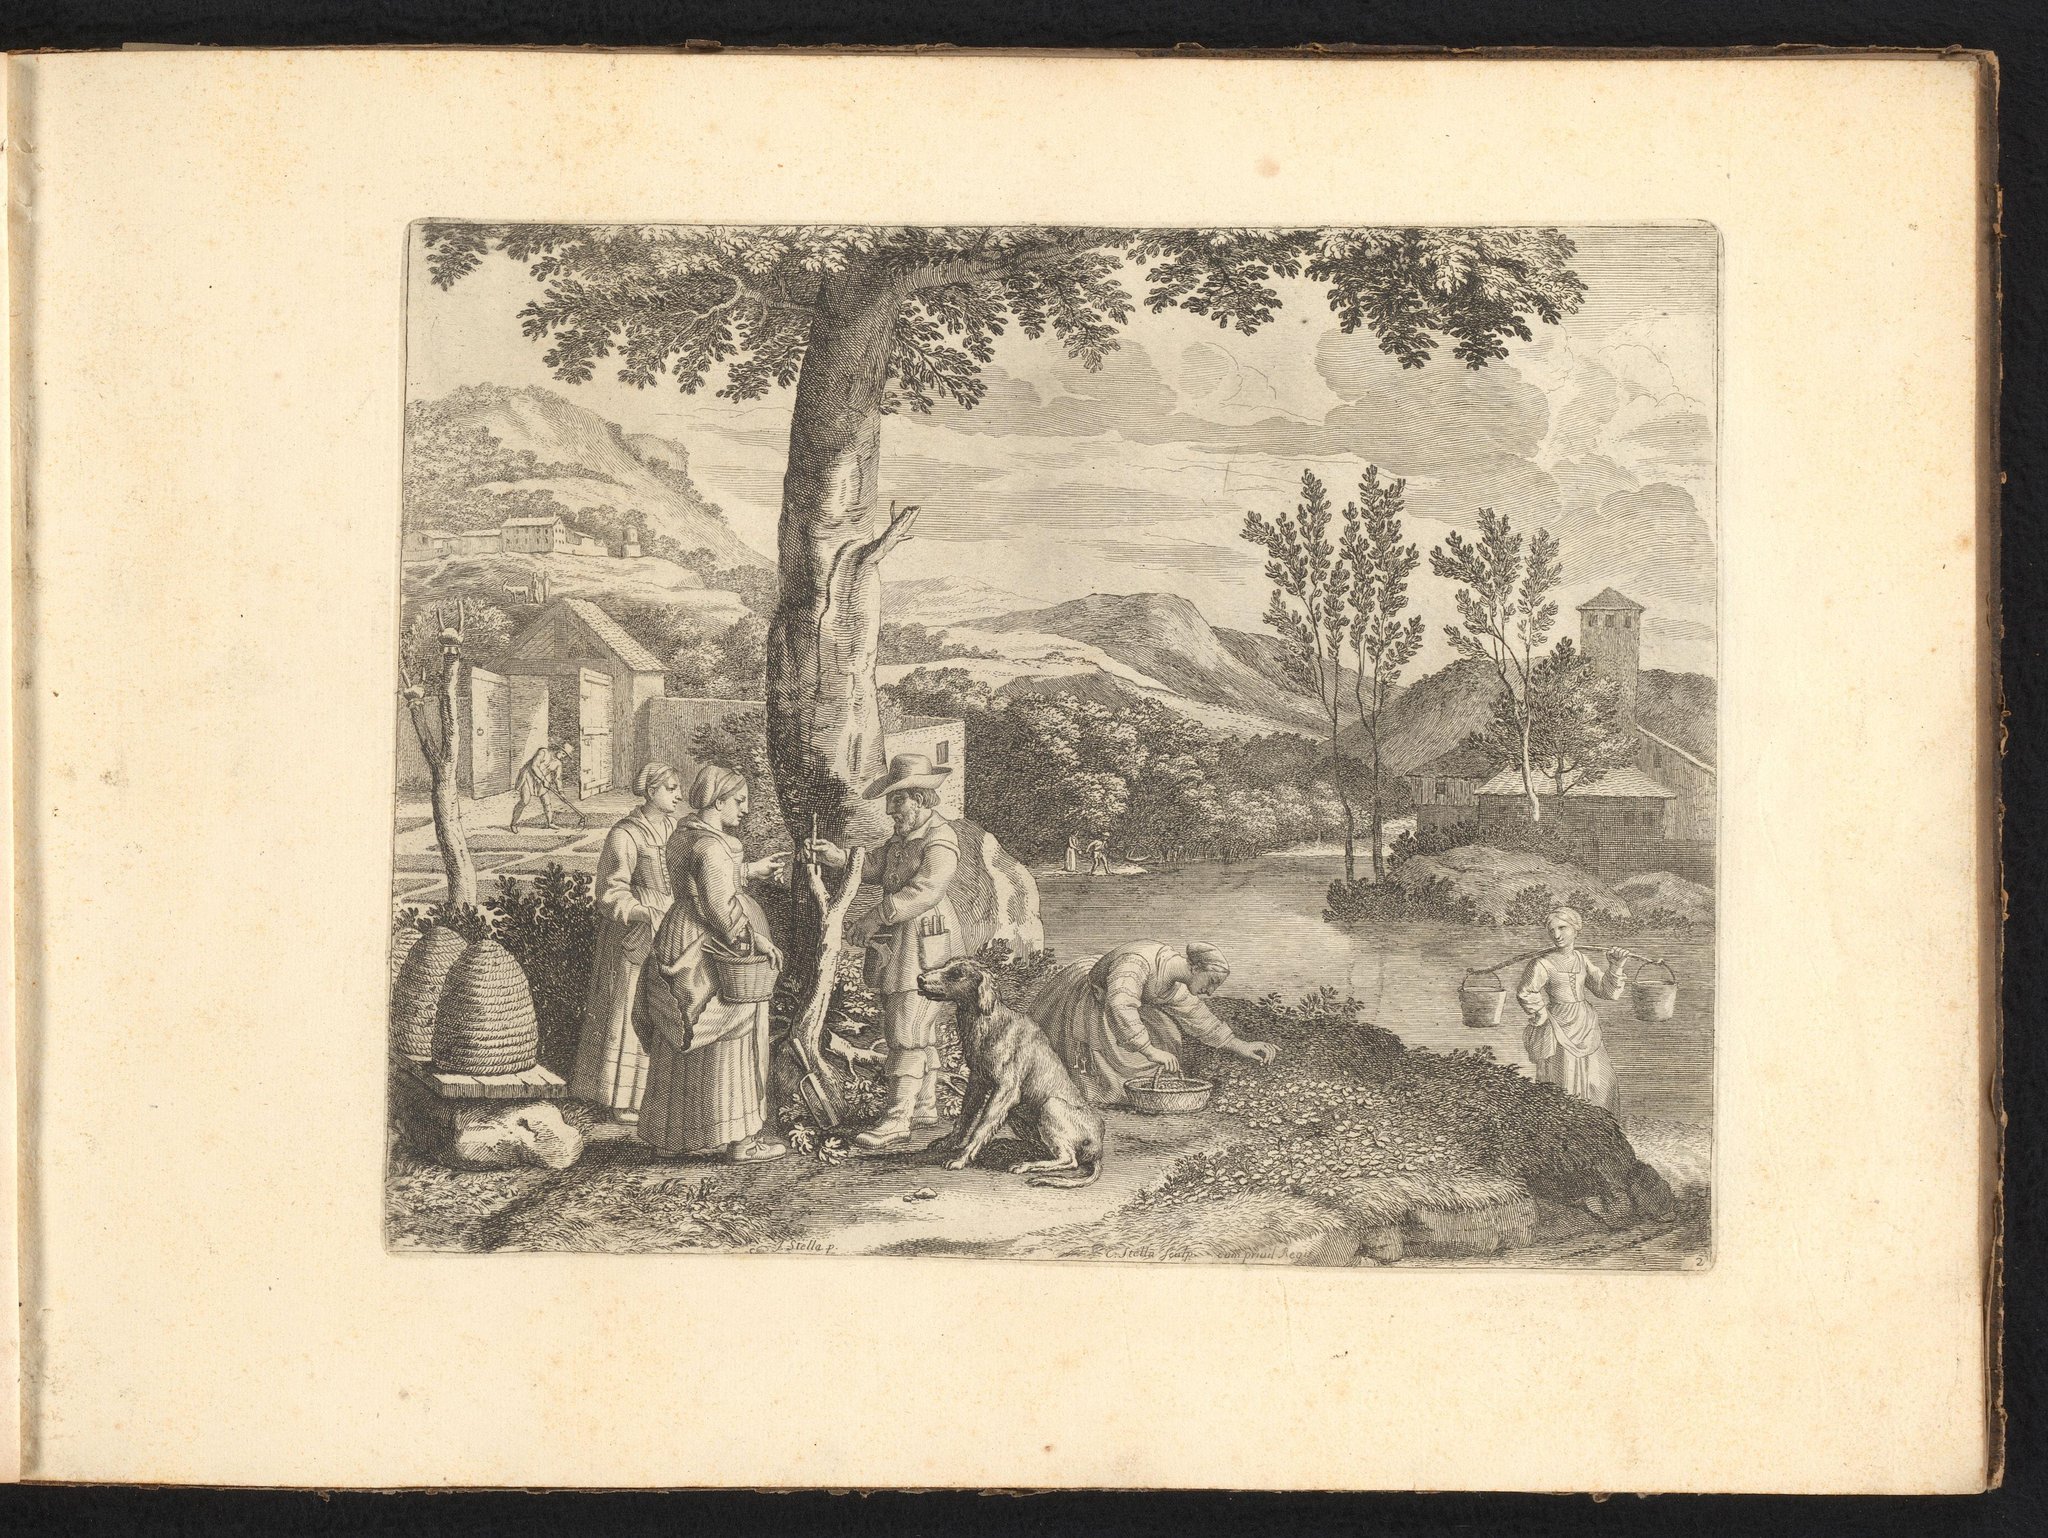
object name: album leaf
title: Pastorales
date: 1667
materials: paper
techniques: engraving, etching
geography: paris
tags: landscapes, forestry, slipping, grafting, cutting of plants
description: Landschap met figuren die bezig zijn met de verzorging van planten en het enten van bomen. Prent maakt deel uit van een album.